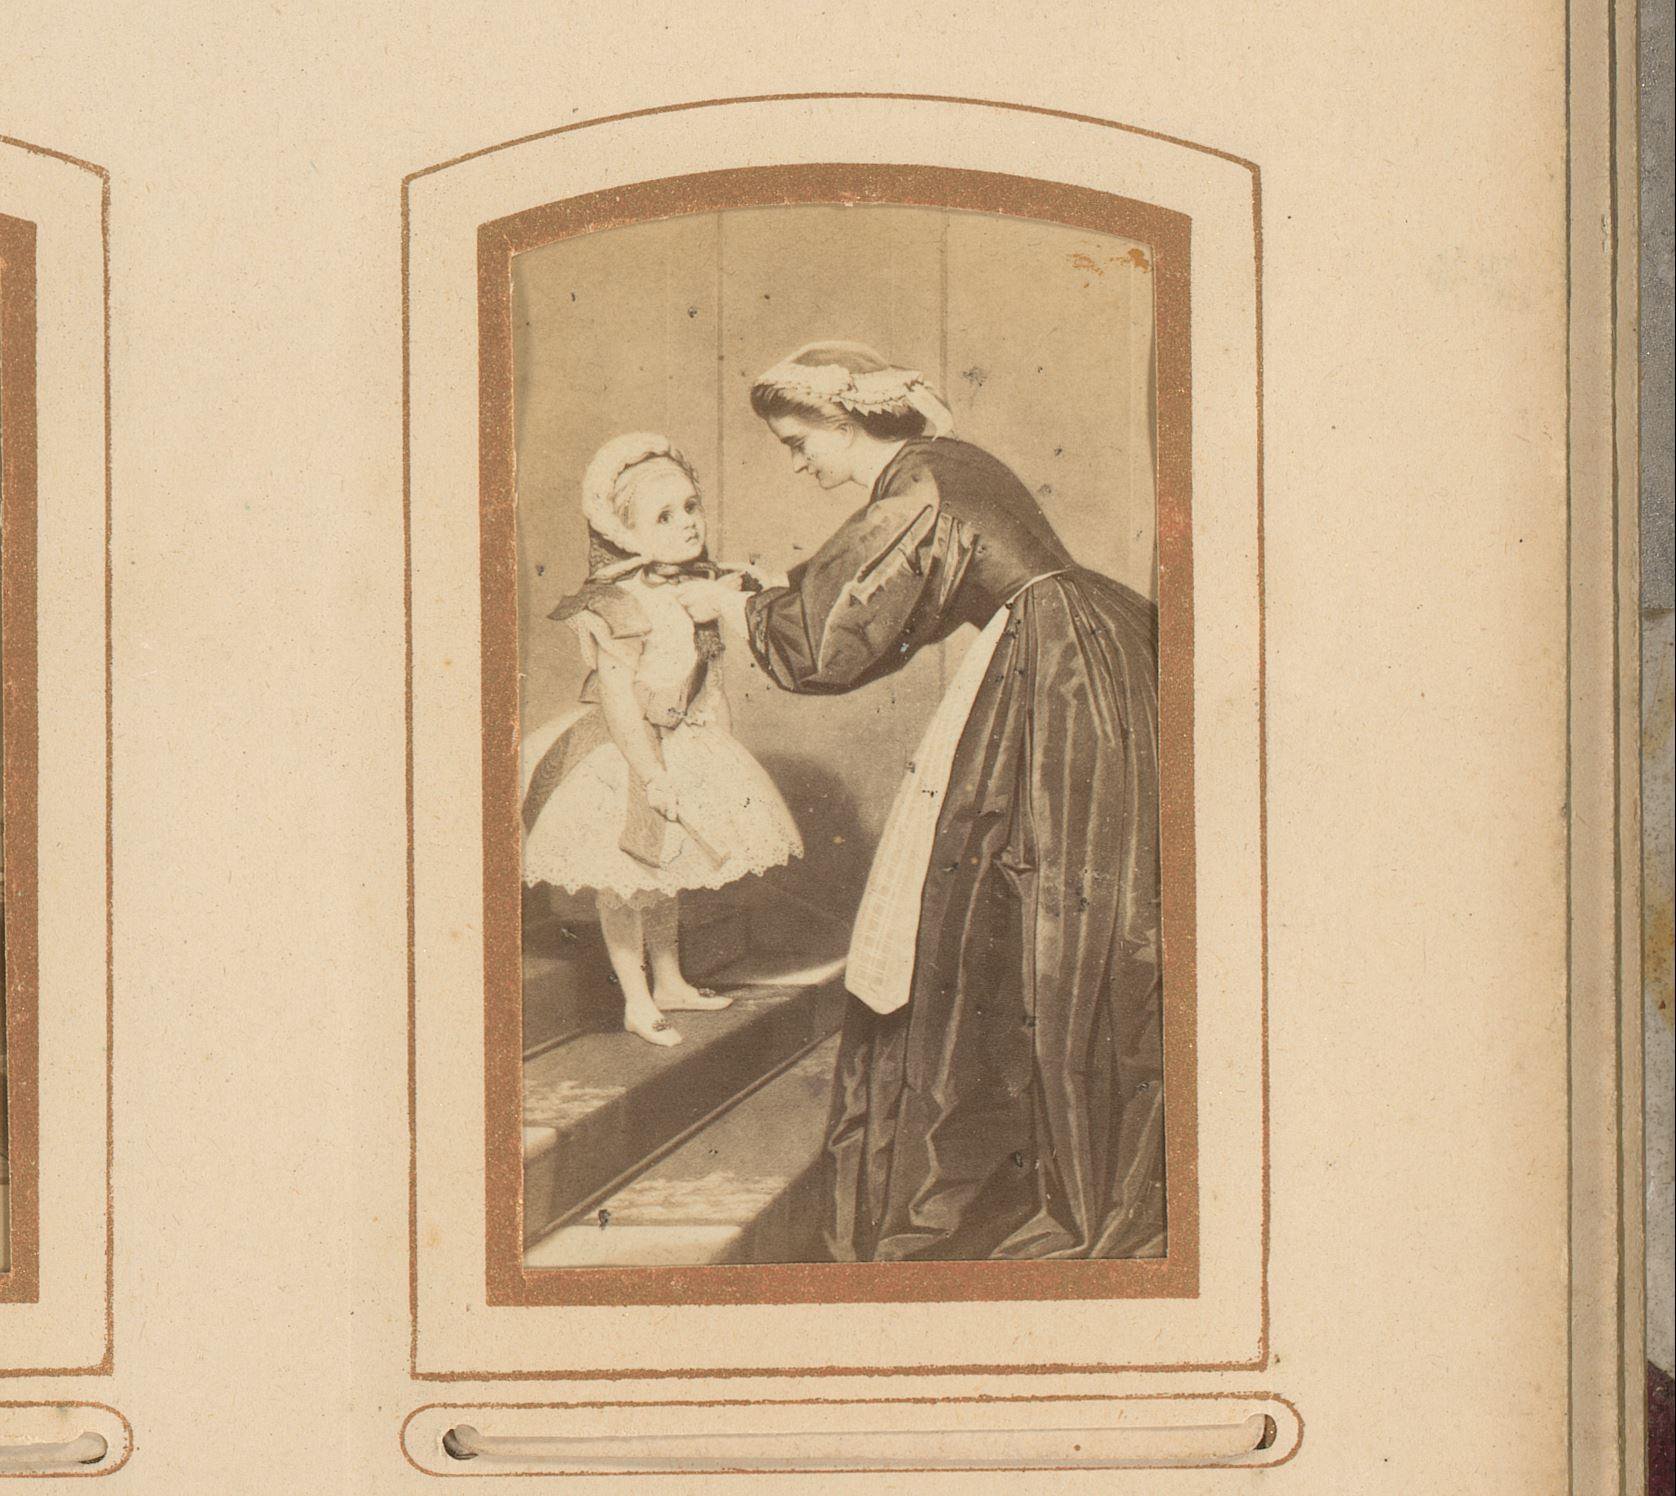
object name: reproduction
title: Fotoreproductie van een schilderij van een vrouw die de hoed van een meisje vastknoopt, staand op een trap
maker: Anonymous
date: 1850-1900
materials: cardboard, photographic support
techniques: albumen print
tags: adult woman, head-gear: hat, staircase, toddler (female)